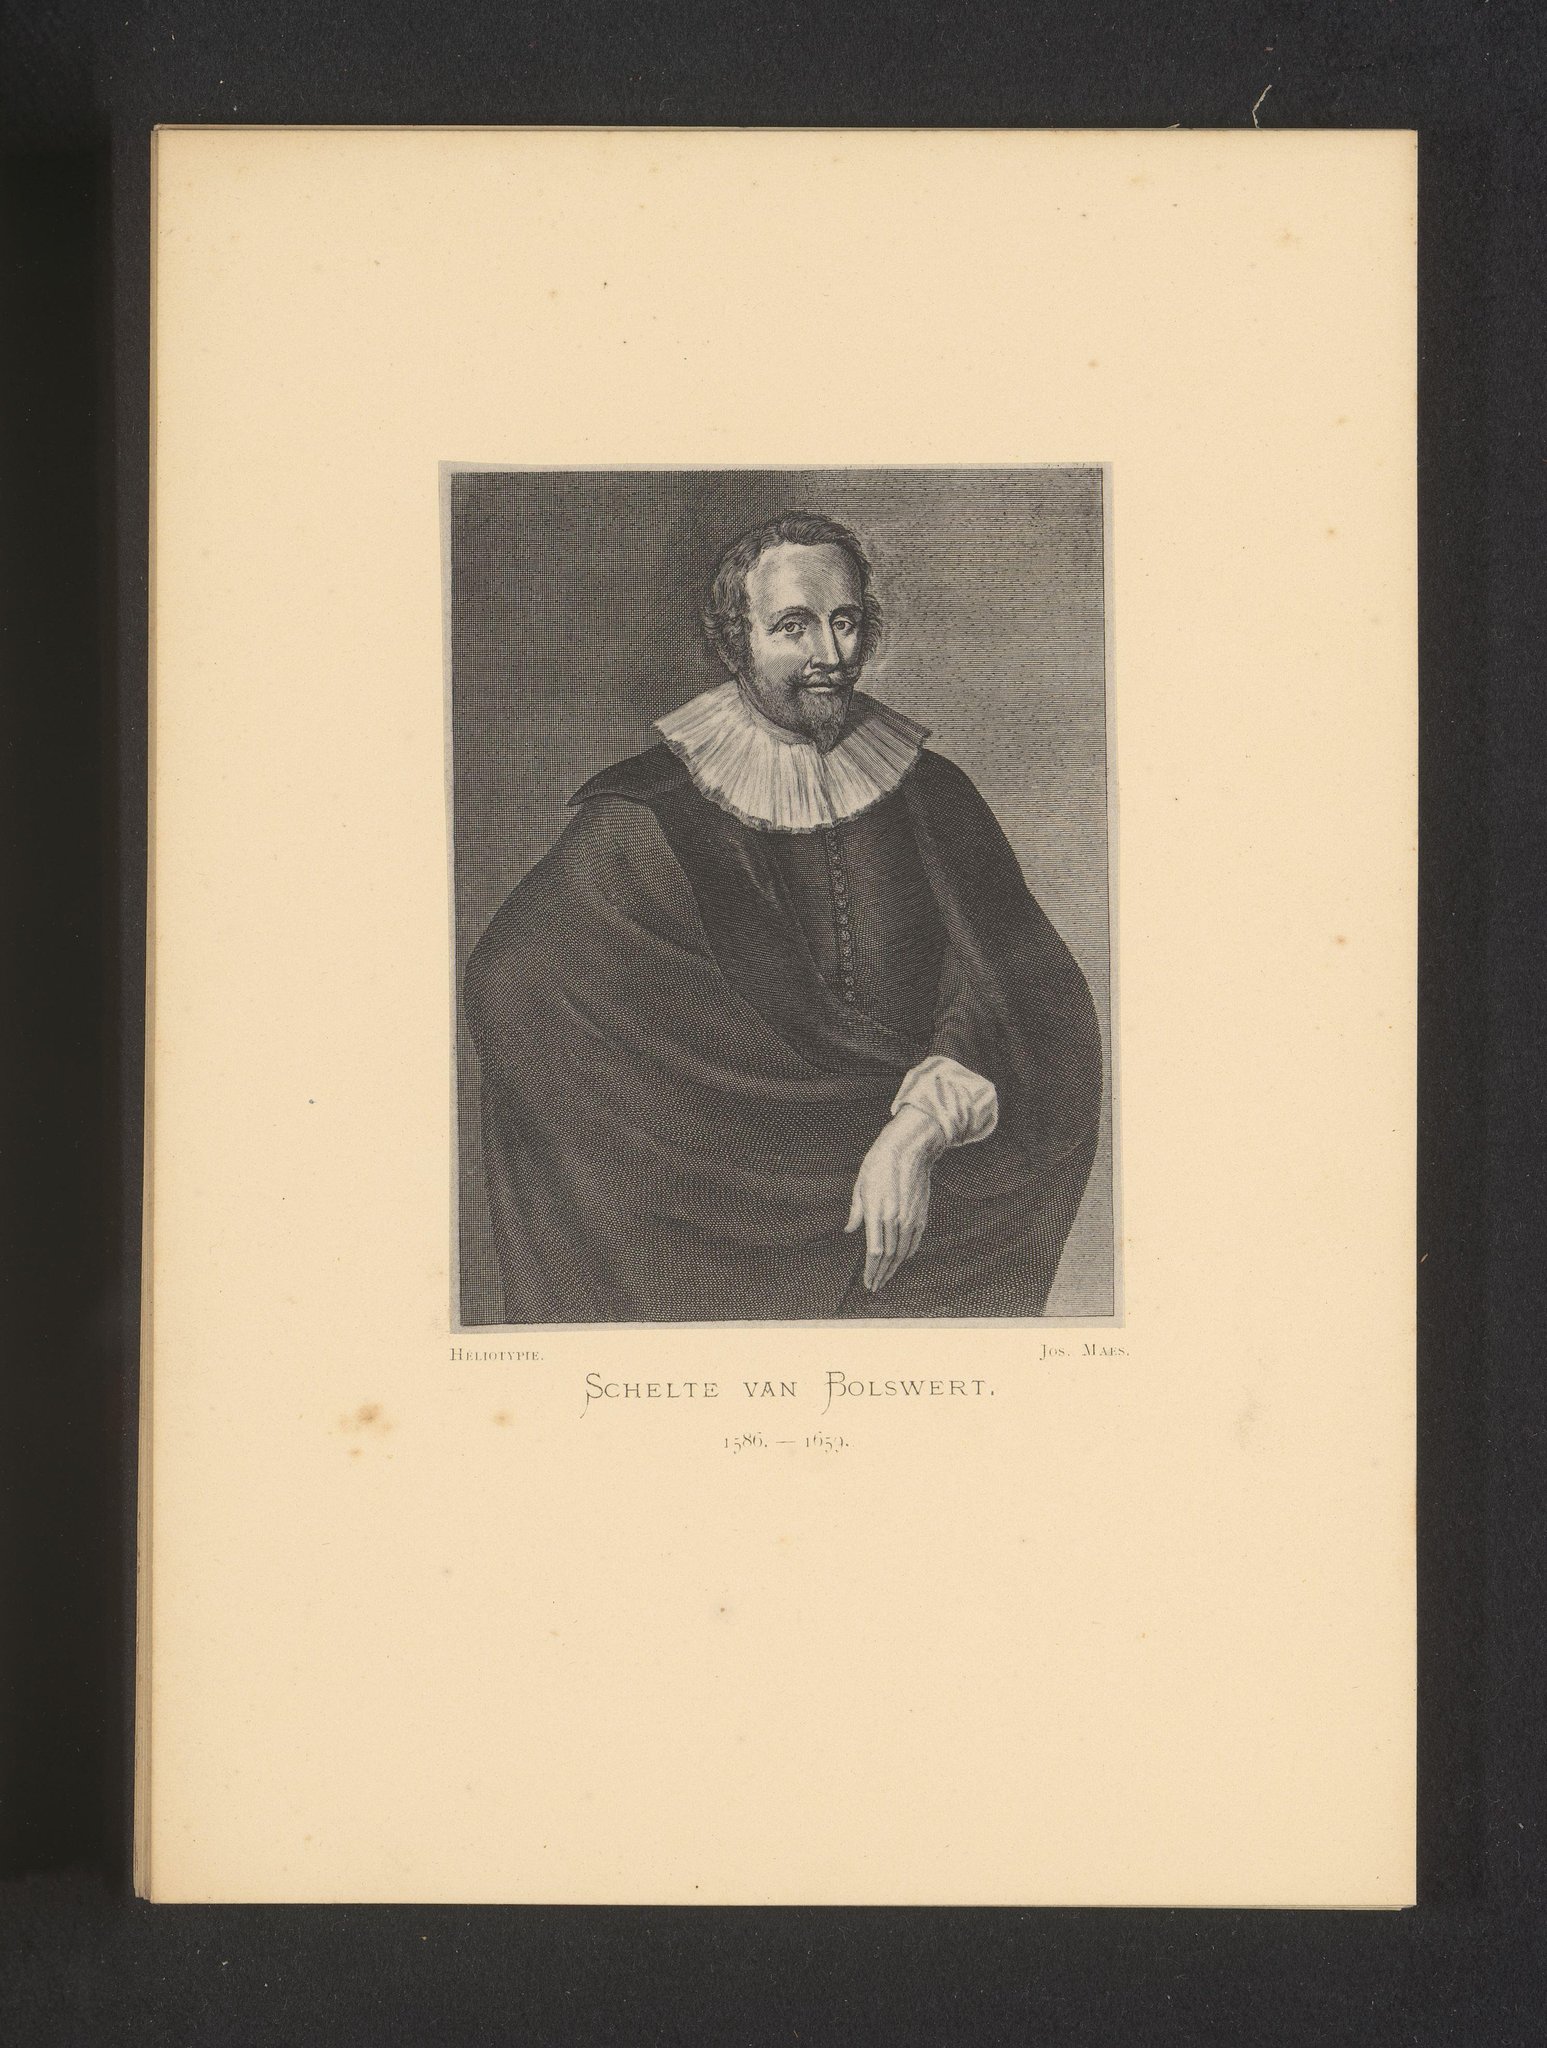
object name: photomechanical print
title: Schelte van Bolswert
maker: joseph maes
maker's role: fotograaf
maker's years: 1838-1908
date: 1872-1877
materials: cardboard, paper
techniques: photograph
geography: antwerp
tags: print maker, schelte adamsz. bolswert, historical persons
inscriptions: inscription: ‘1586. - 1659.’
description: Deze prent maakt deel uit van een omslag met 150 prenten en een katern met een lijst van afbeeldingen.